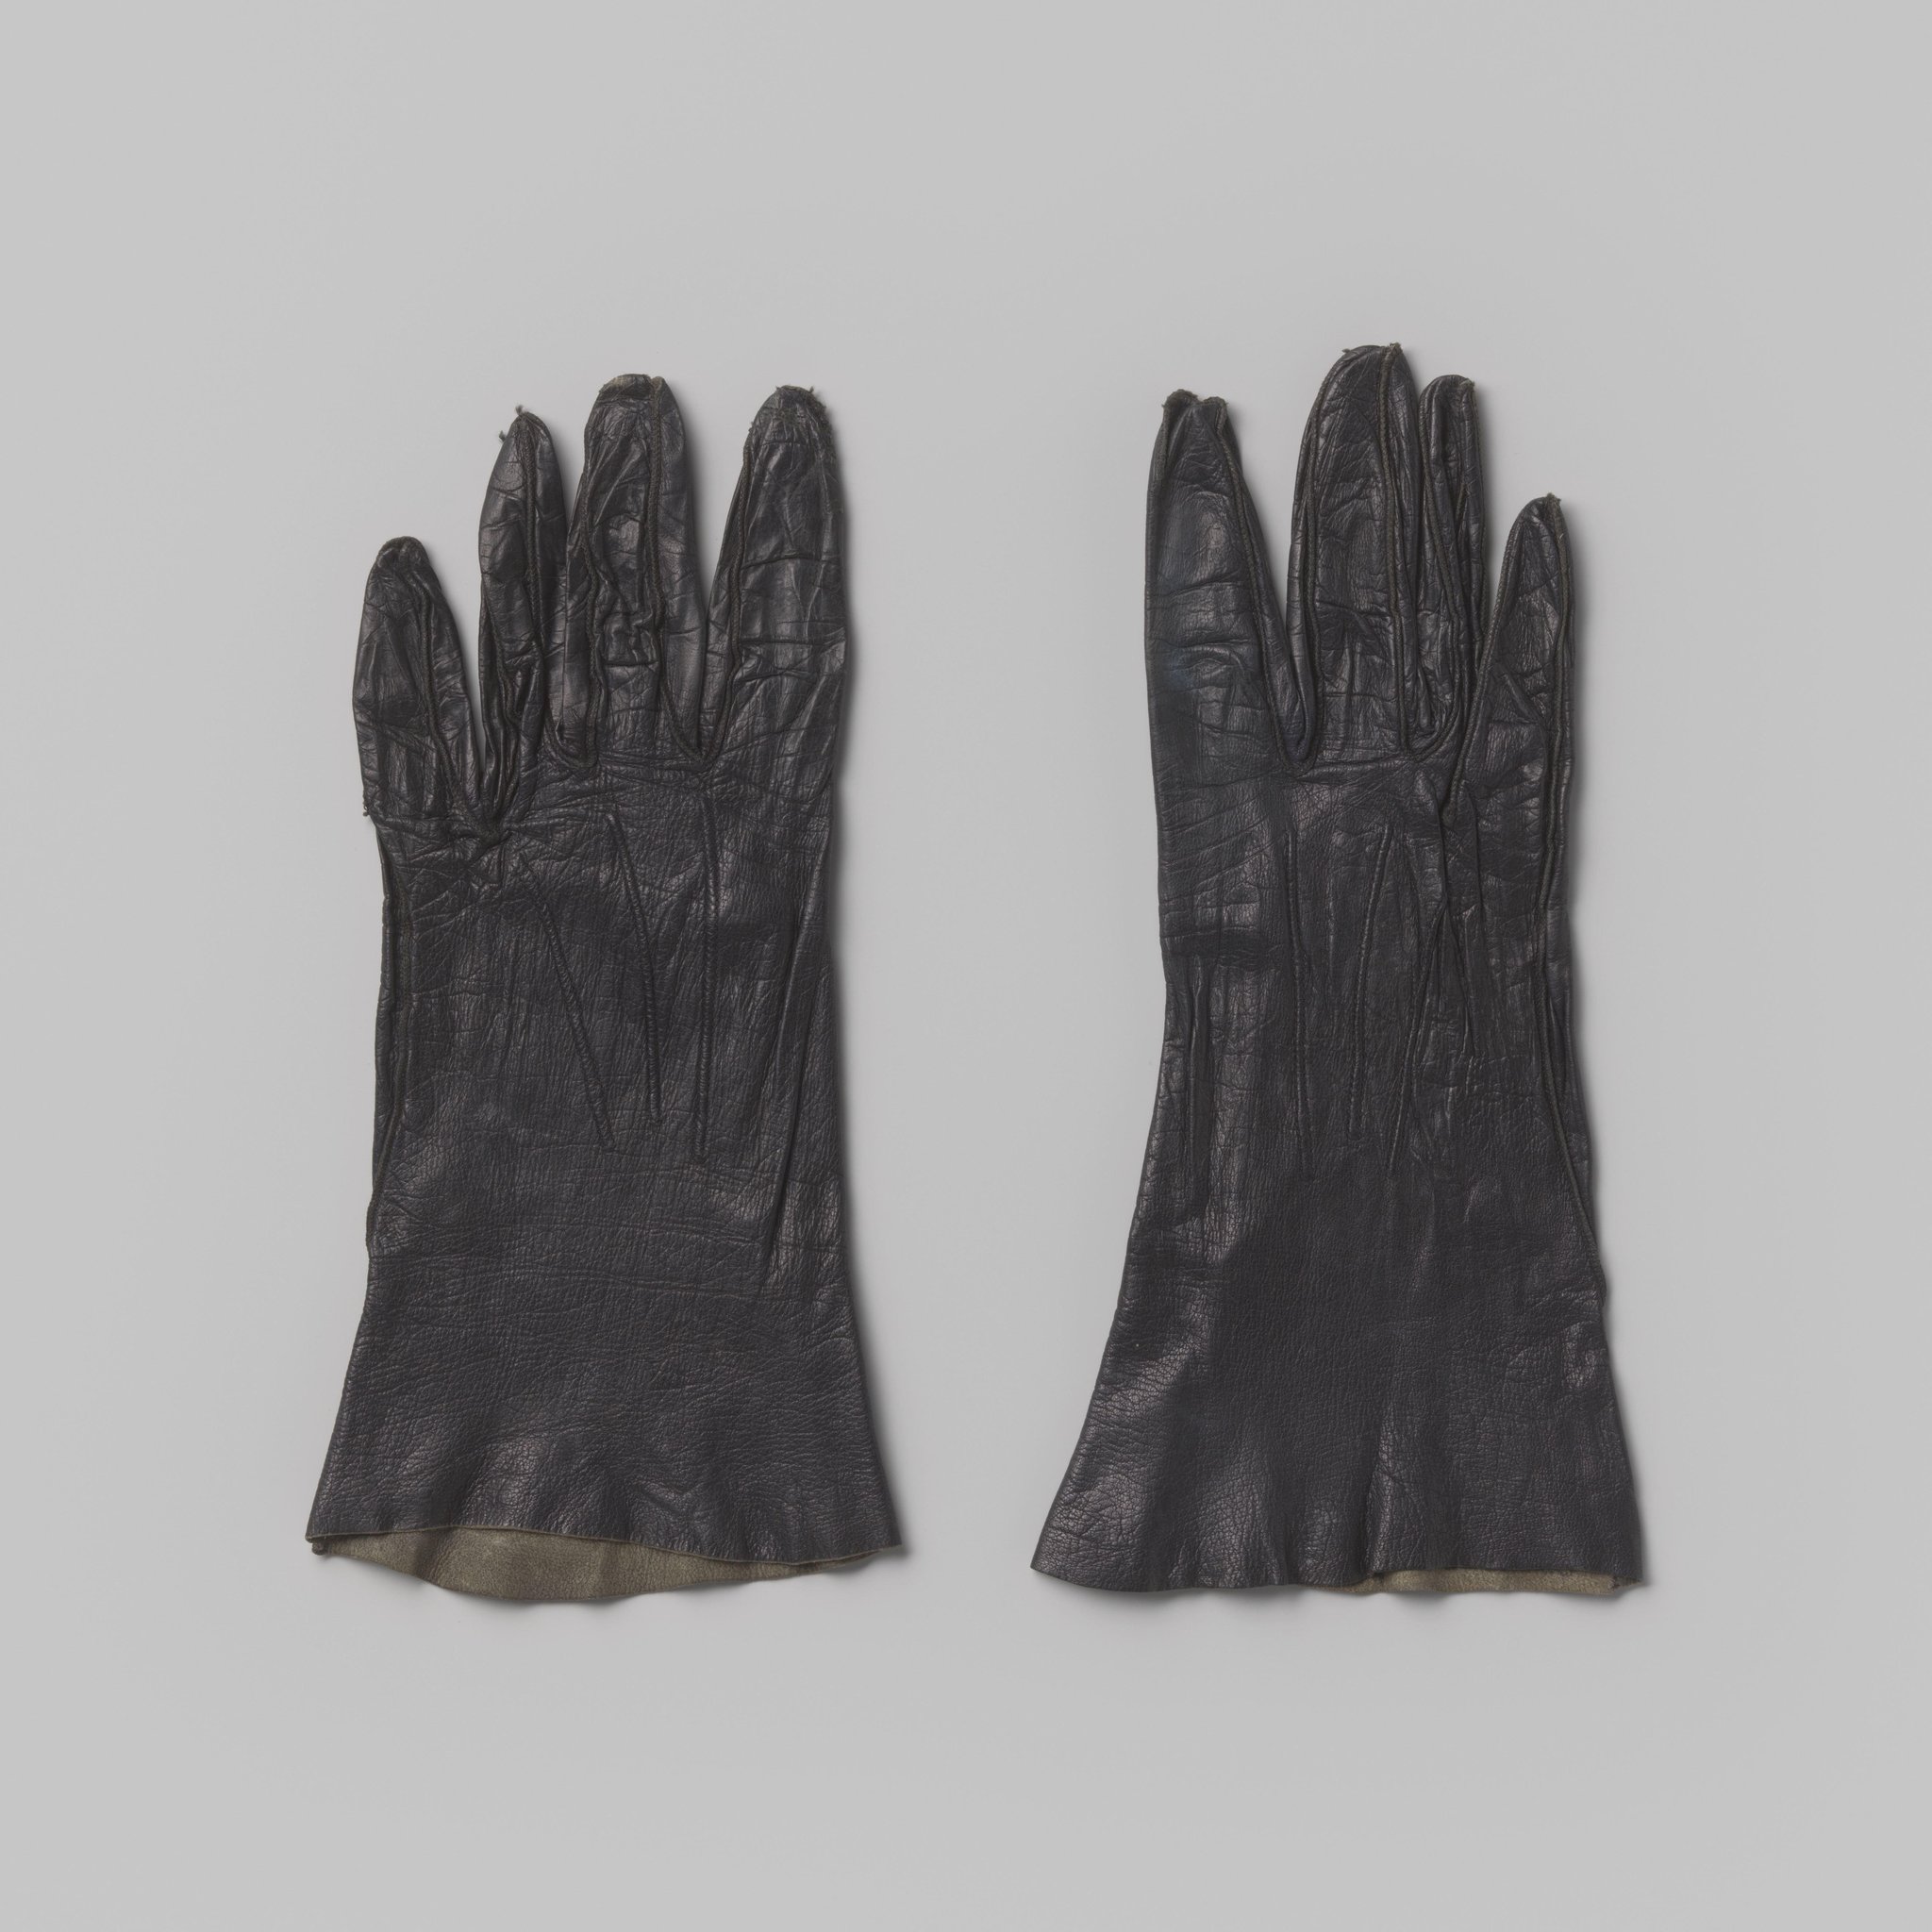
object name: glove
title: Handschoen van zwart glacéleer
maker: Anonymous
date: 1950-1960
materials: glazing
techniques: glazing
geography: amsterdam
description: Linker dameshandschoen van zwart glacéleer. Model: kort, met drie peesnaadjes op de handrug.